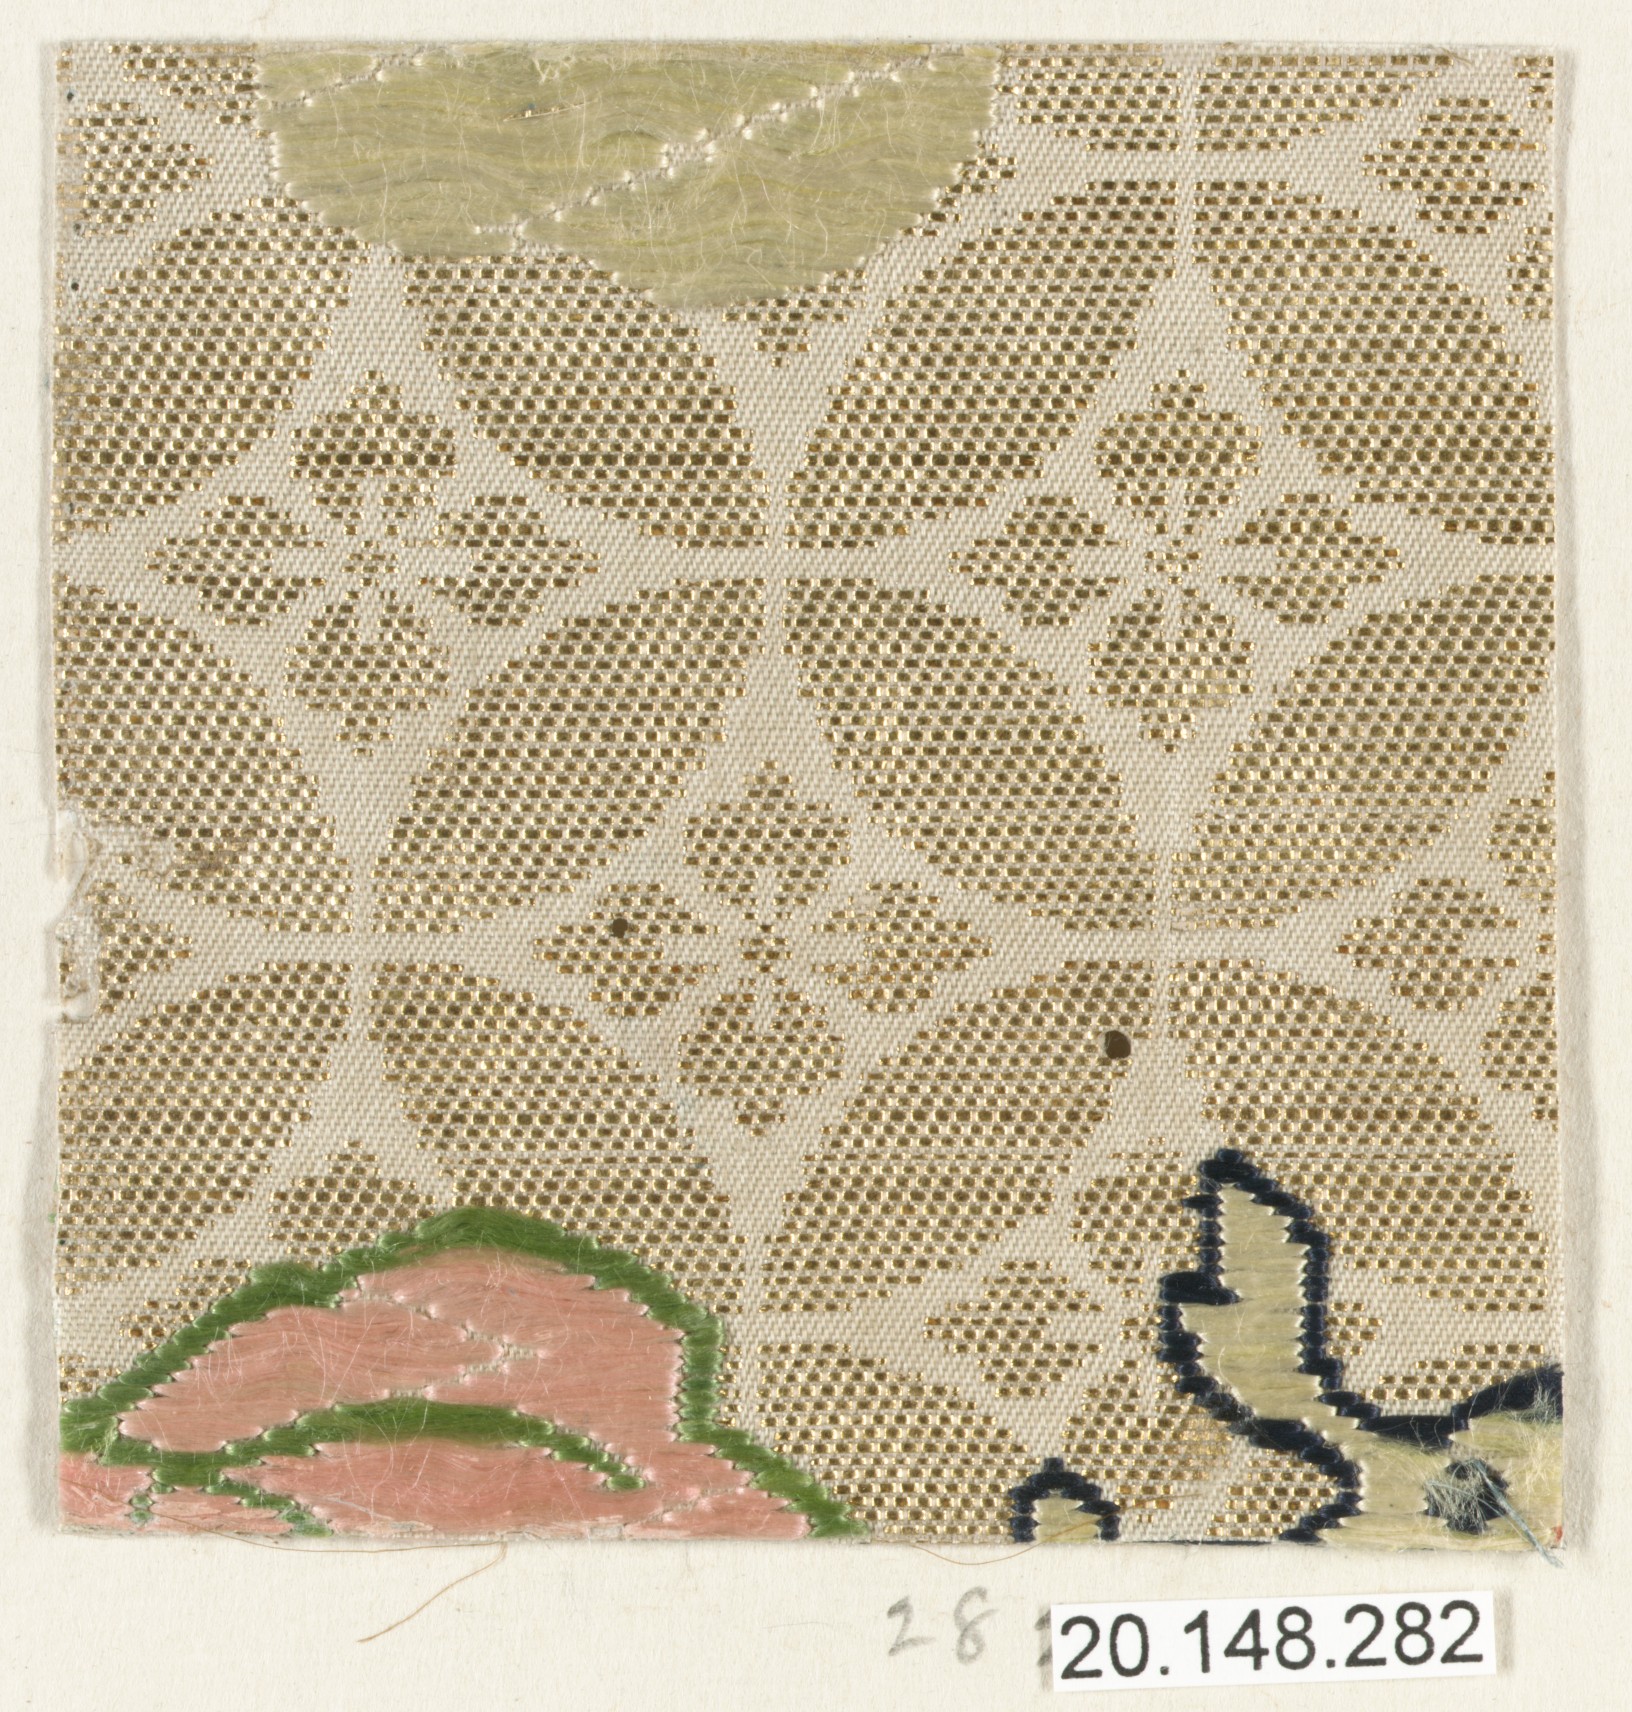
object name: piece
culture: japanese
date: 1701-1800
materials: silk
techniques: compound weave